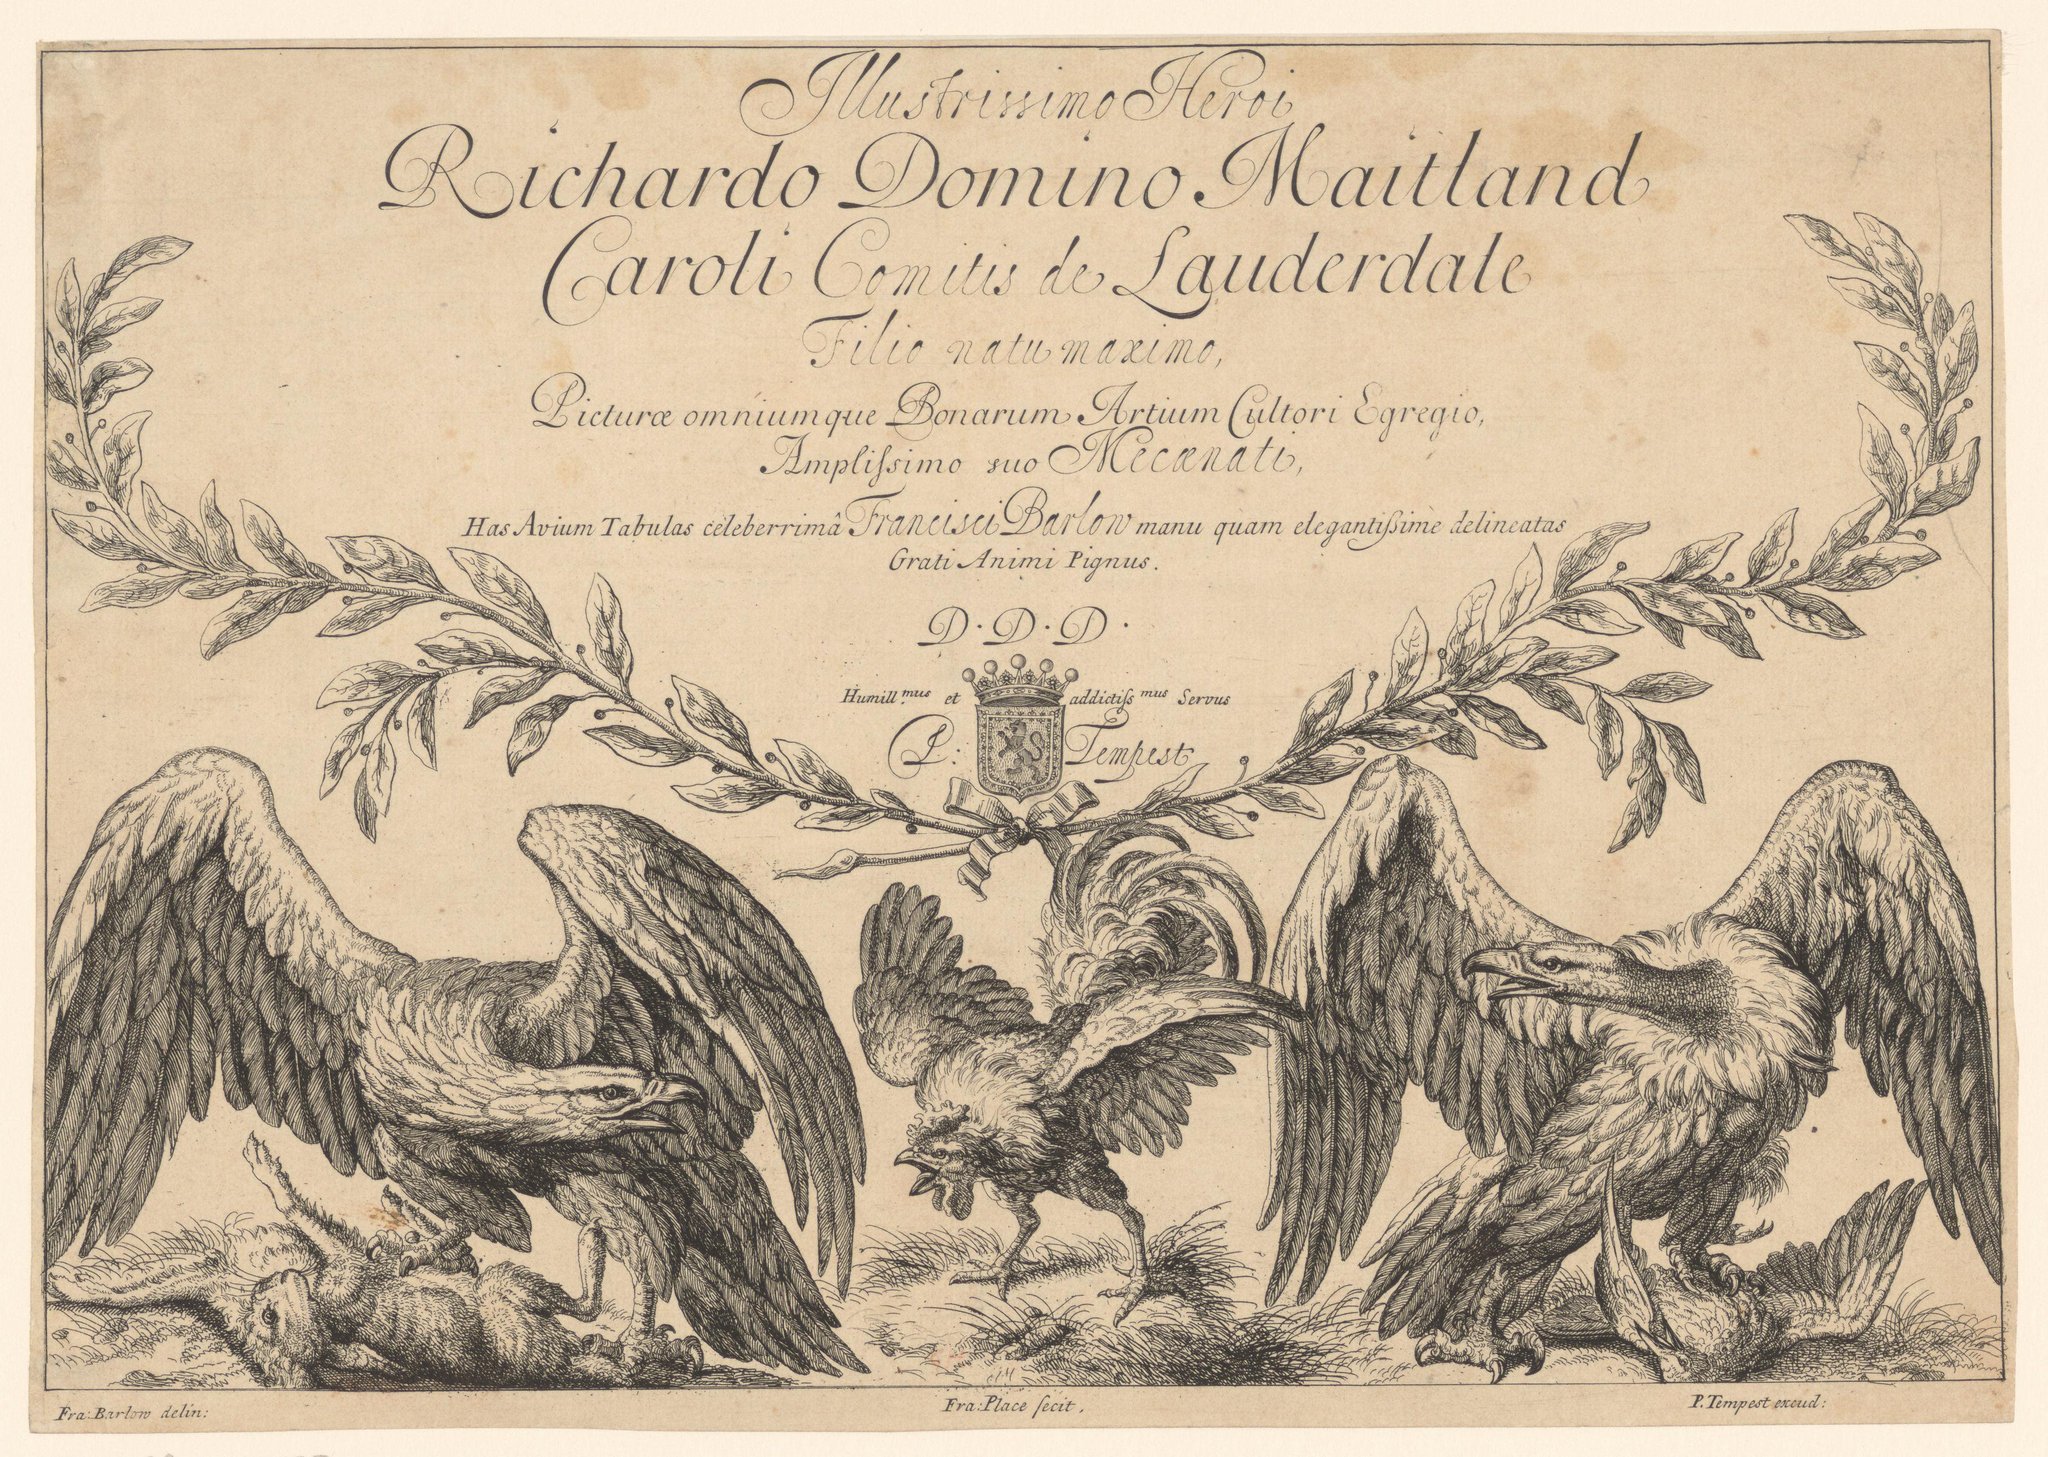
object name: print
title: Voorstellingen van vogels opgedragen aan John Maitland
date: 1686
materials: paper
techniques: etching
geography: great britain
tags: predatory birds: eagle, rodents: hare, predatory birds: vulture, fowl (cock, hen, chicken, etc.)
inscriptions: collector's mark: Lugt 2228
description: De adelaar en gier houden een haas en vogel tegen de grond.